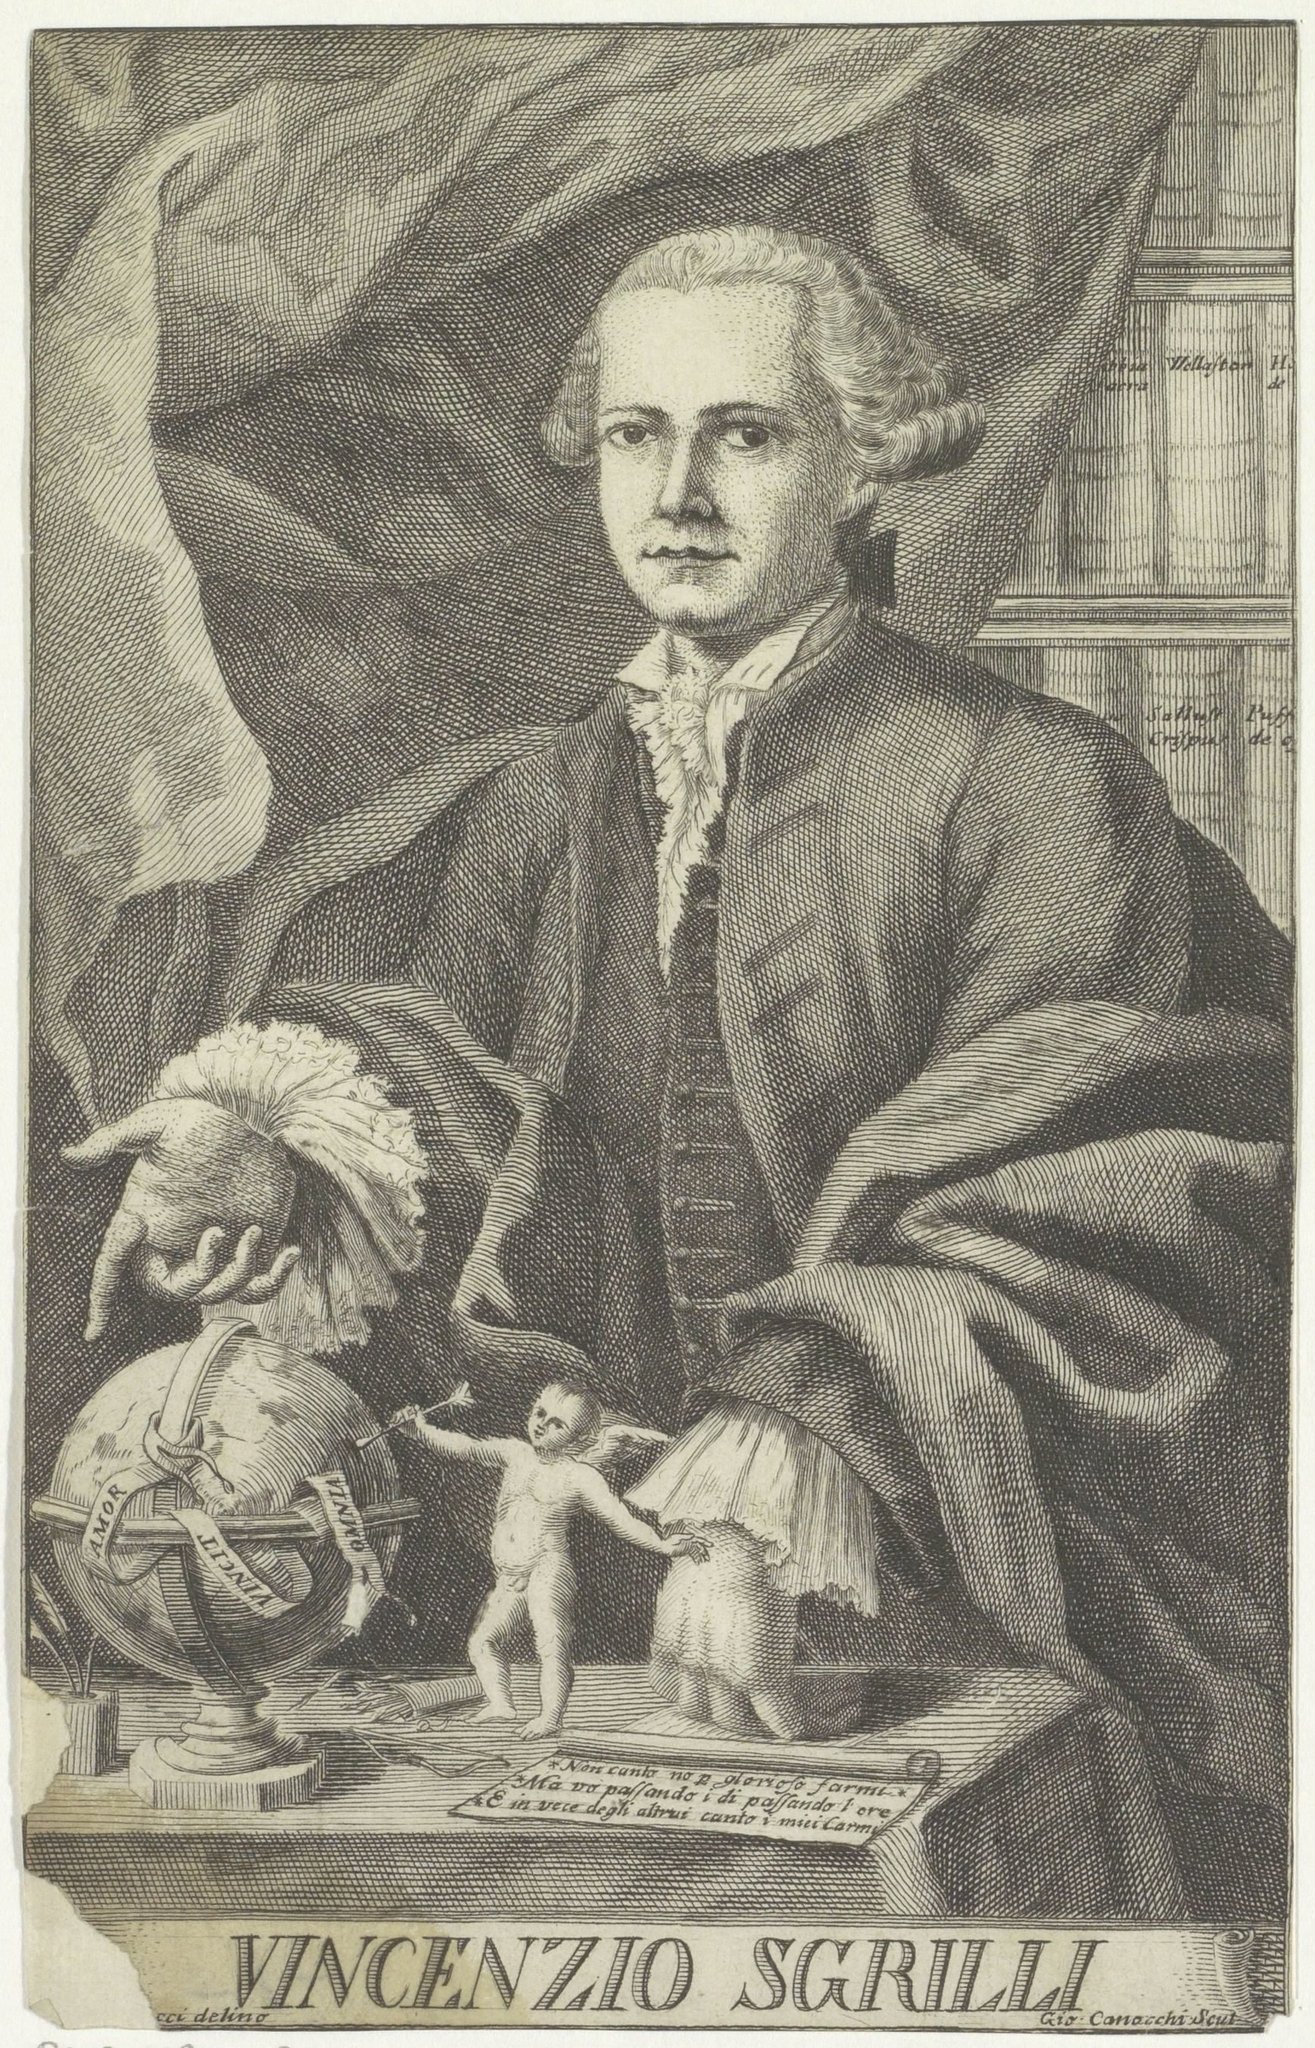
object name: print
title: Portret van Vincenzio Sgrilli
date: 1700-1799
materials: paper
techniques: engraving, etching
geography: italy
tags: historical persons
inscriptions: collector's mark: Lugt 2228